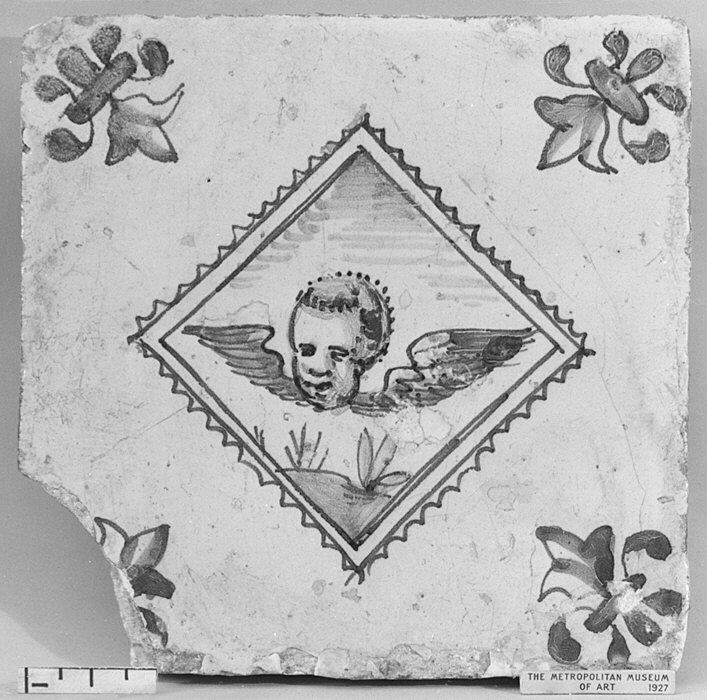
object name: tile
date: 1640-1660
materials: earthenware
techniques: glazing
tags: putti